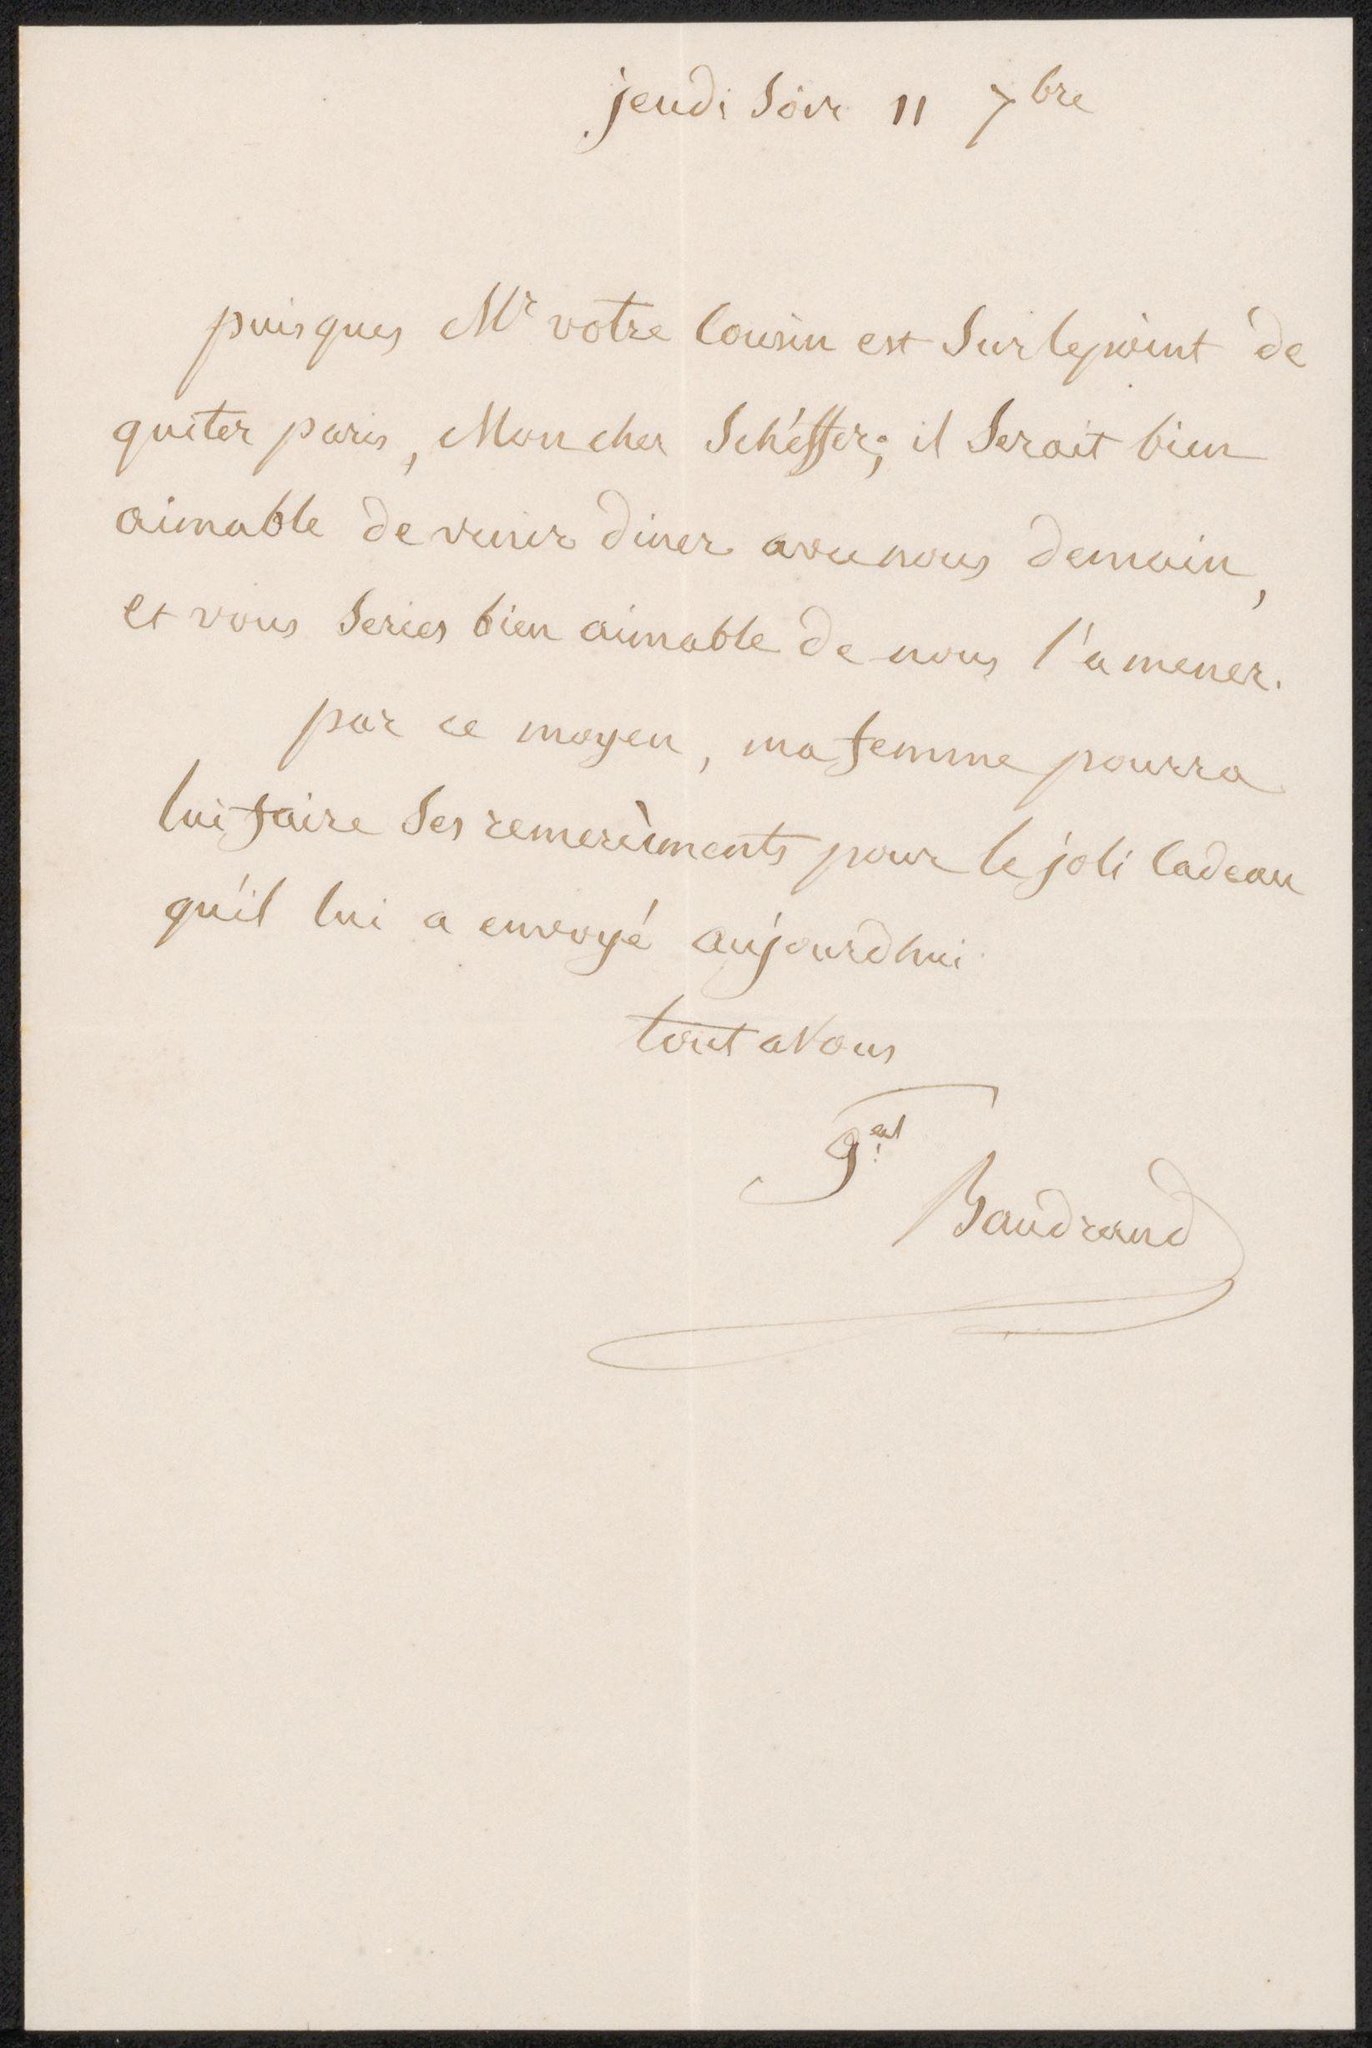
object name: letter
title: Brief aan Ary Scheffer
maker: marie étienne françois henri baudrand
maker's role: generaal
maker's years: 1774-1848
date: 1805-1848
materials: ink, paper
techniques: pen, writing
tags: ary scheffer, dordrecht, print maker, draughtsman, ary johannes lamme, paris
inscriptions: collector's mark: Lugt 2228